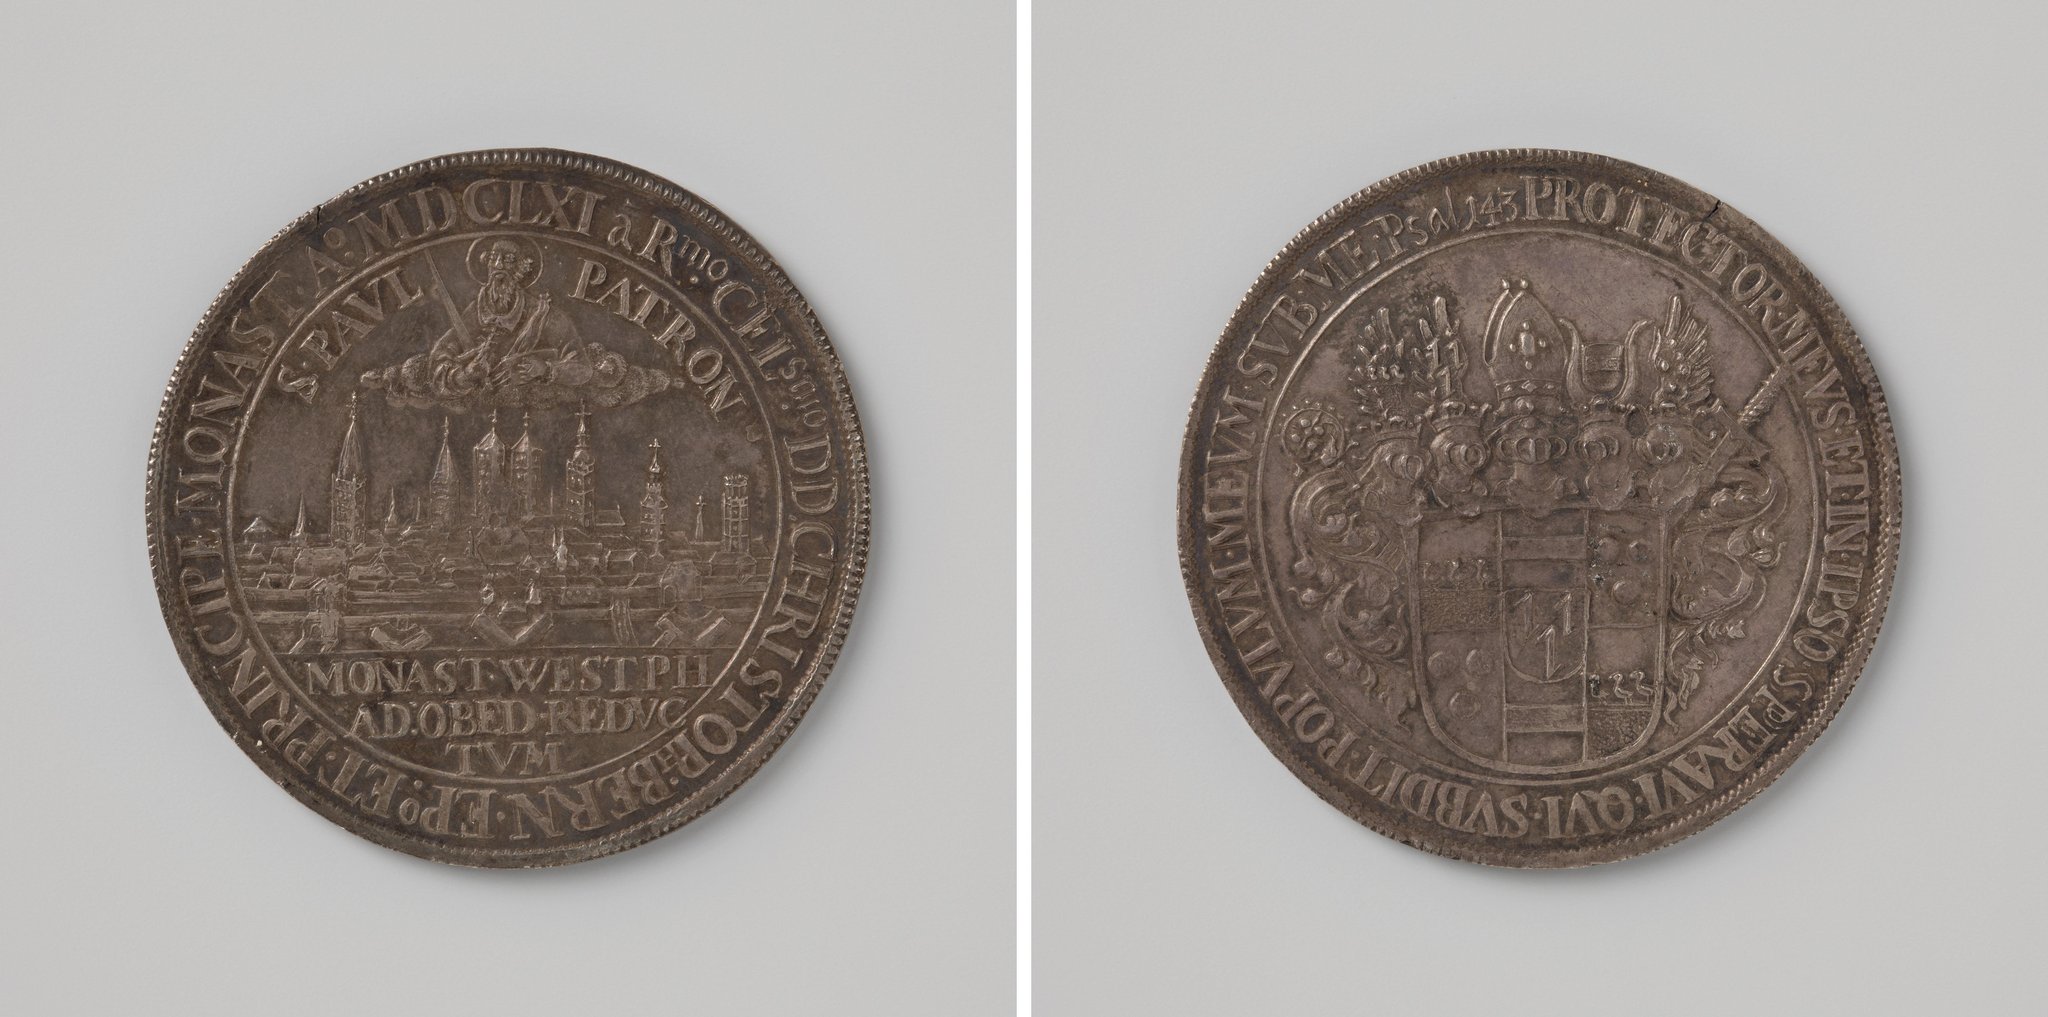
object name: history medal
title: Inname van Munster door Bernhard van Galen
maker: Anonymous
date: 1661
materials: silver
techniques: striking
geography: germany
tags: christoph bernhard von galen, münster, beleg van munster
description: Zilveren penning. Voorzijde: gezicht op stad (Munster), daarboven in wolk Paulus, binnen omschrift. Keerzijde: bisschoppelijk wapenschild binnen omschrift